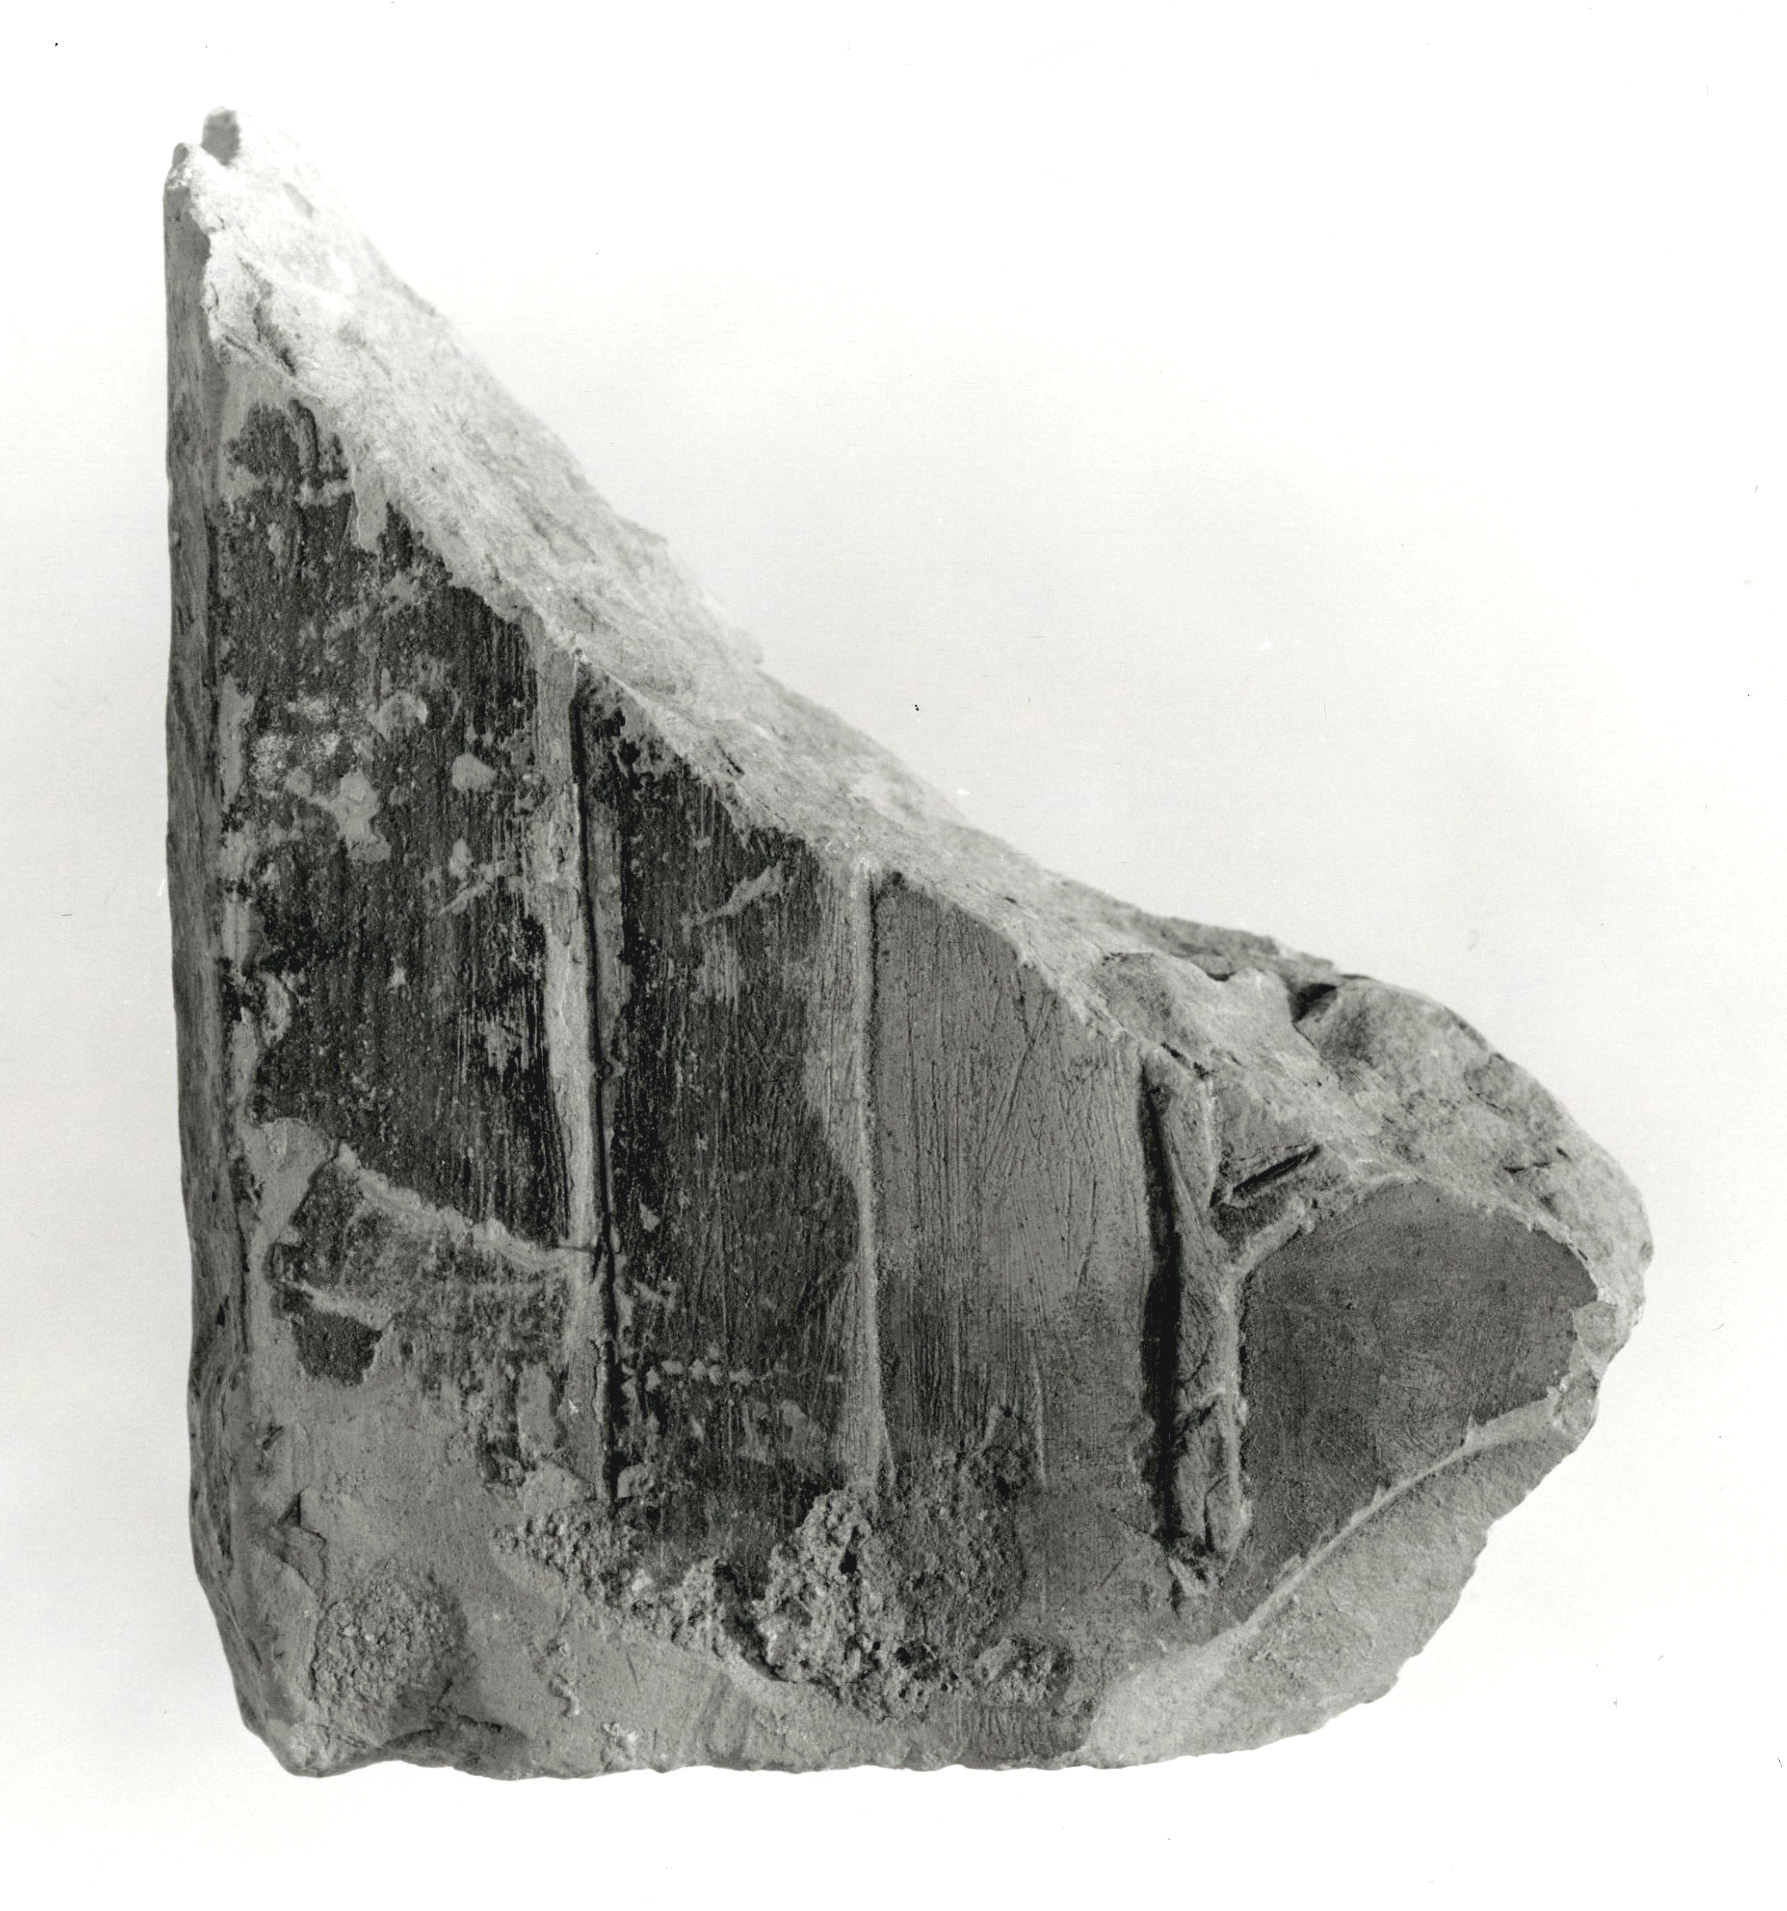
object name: relief, tomb of nespekashuty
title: Raised relief fragment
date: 664-610 BCE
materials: limestone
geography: egypt